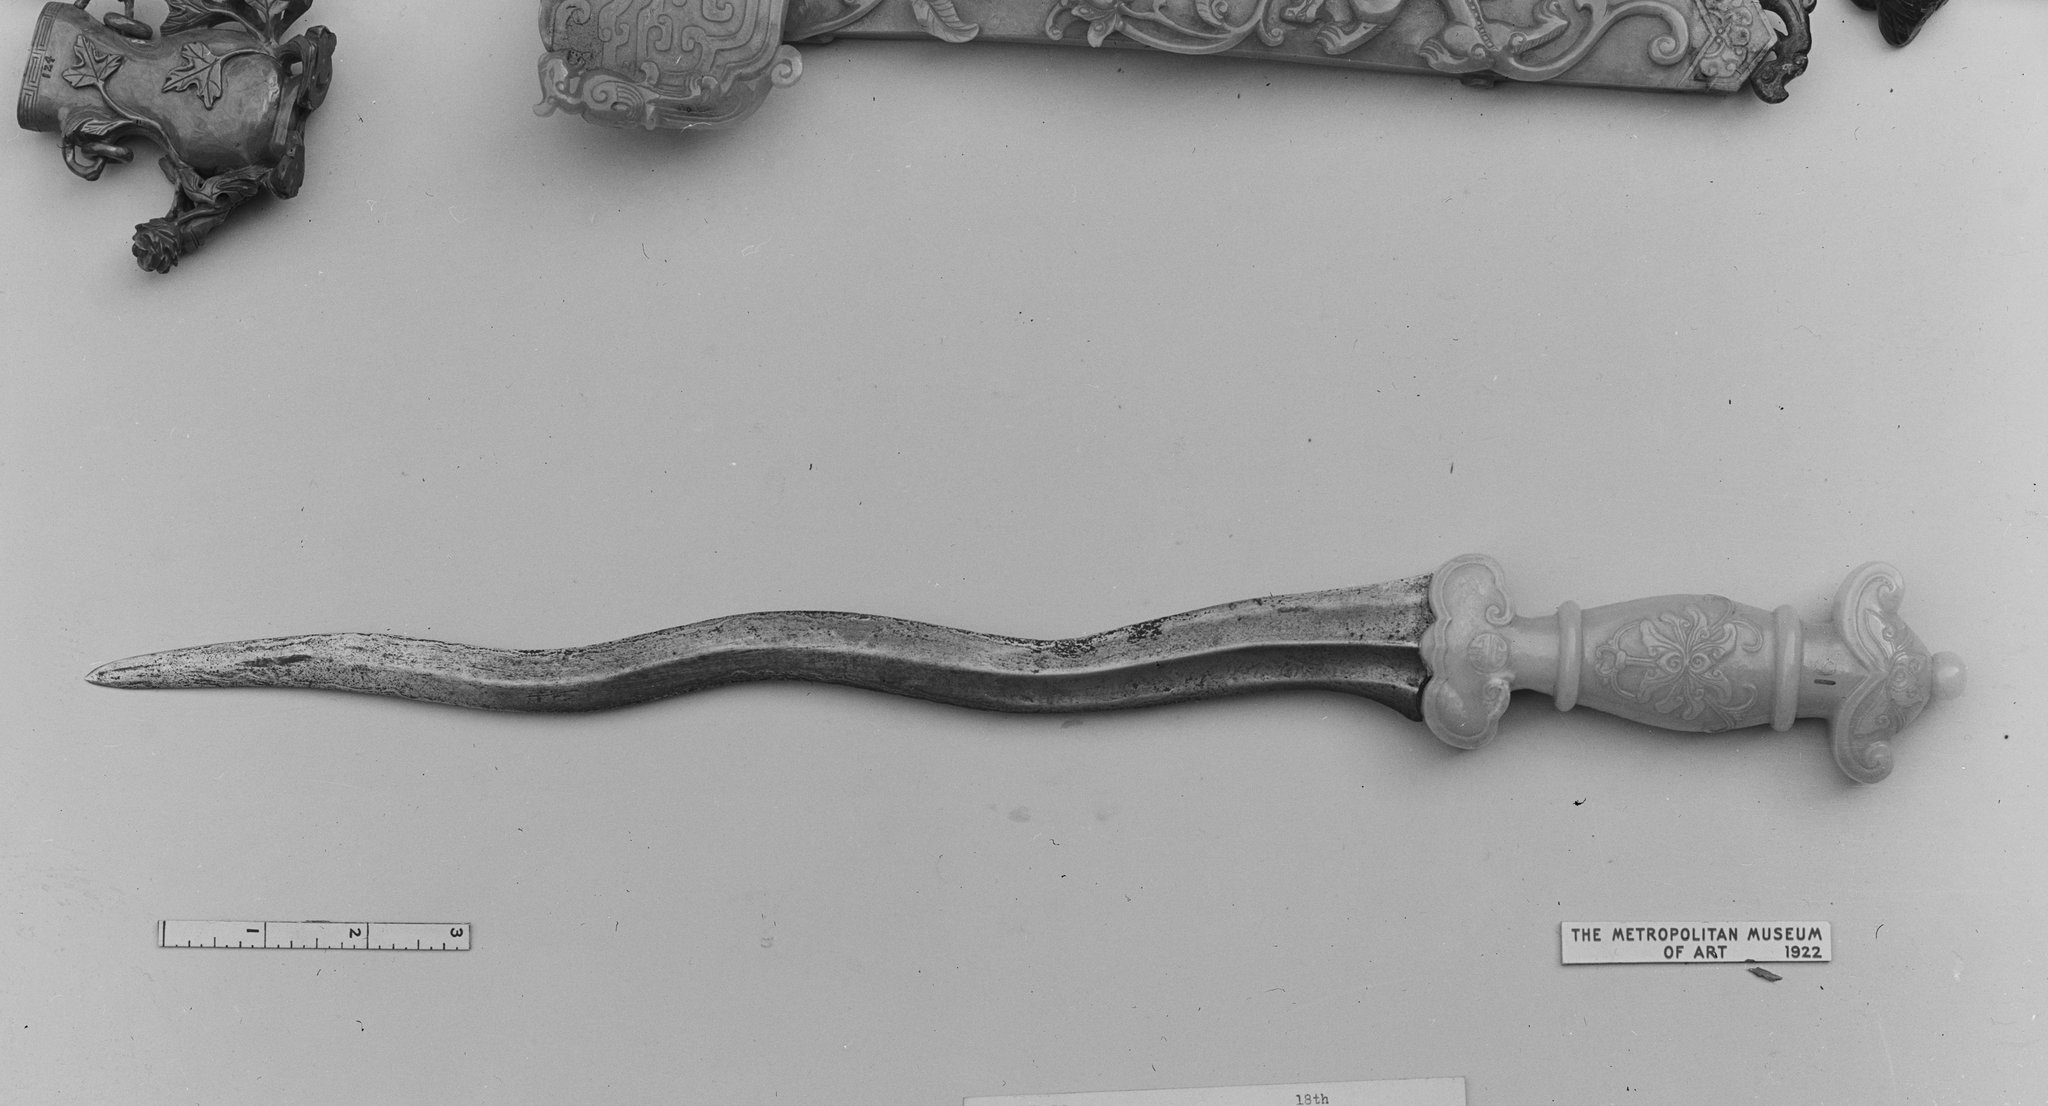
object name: dagger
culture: chinese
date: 1701-1800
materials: jade